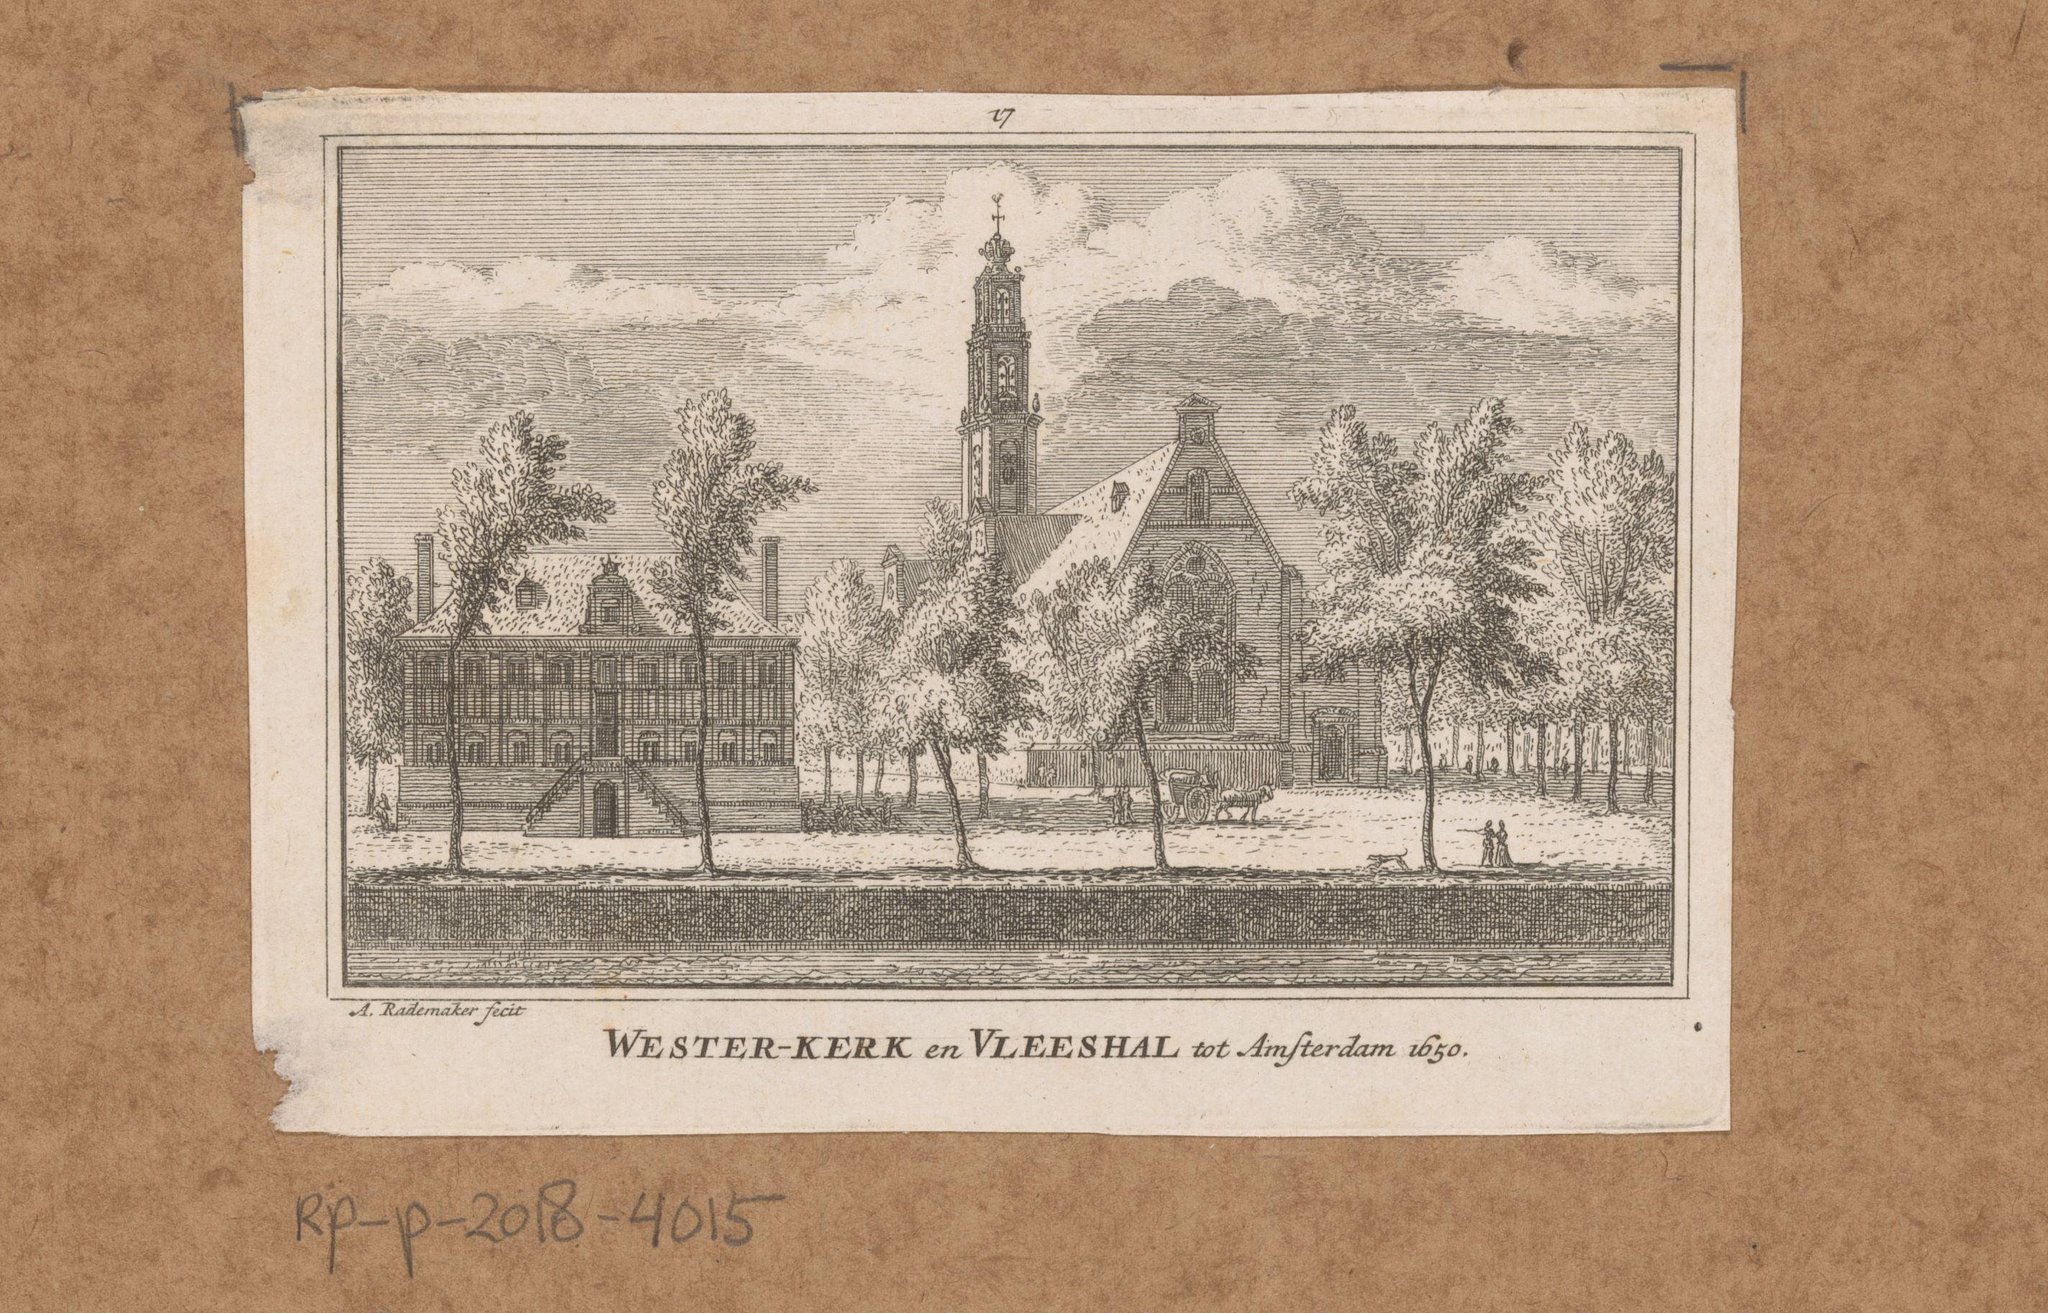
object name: book illustration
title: Wester-Kerk en Vleeshal tot Amsterdam 1650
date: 1725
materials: paper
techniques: etching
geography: amsterdam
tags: church (exterior), canals, waters (in city), market-hall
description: Prent voor het eerst gebruikt in: Rademaker, Abraham. Kabinet van Nederlandsche outheden en gezichten: vervat in 300 konstplaaten (…). 2 dln. Amsterdam: Willem Barents, 1725, dl. 1, ill. 17. Daarna is de prent in verschillende heruitgaven verschenen, uitgegeven in 1727-1733, 1770-1771 en 1792-1803.